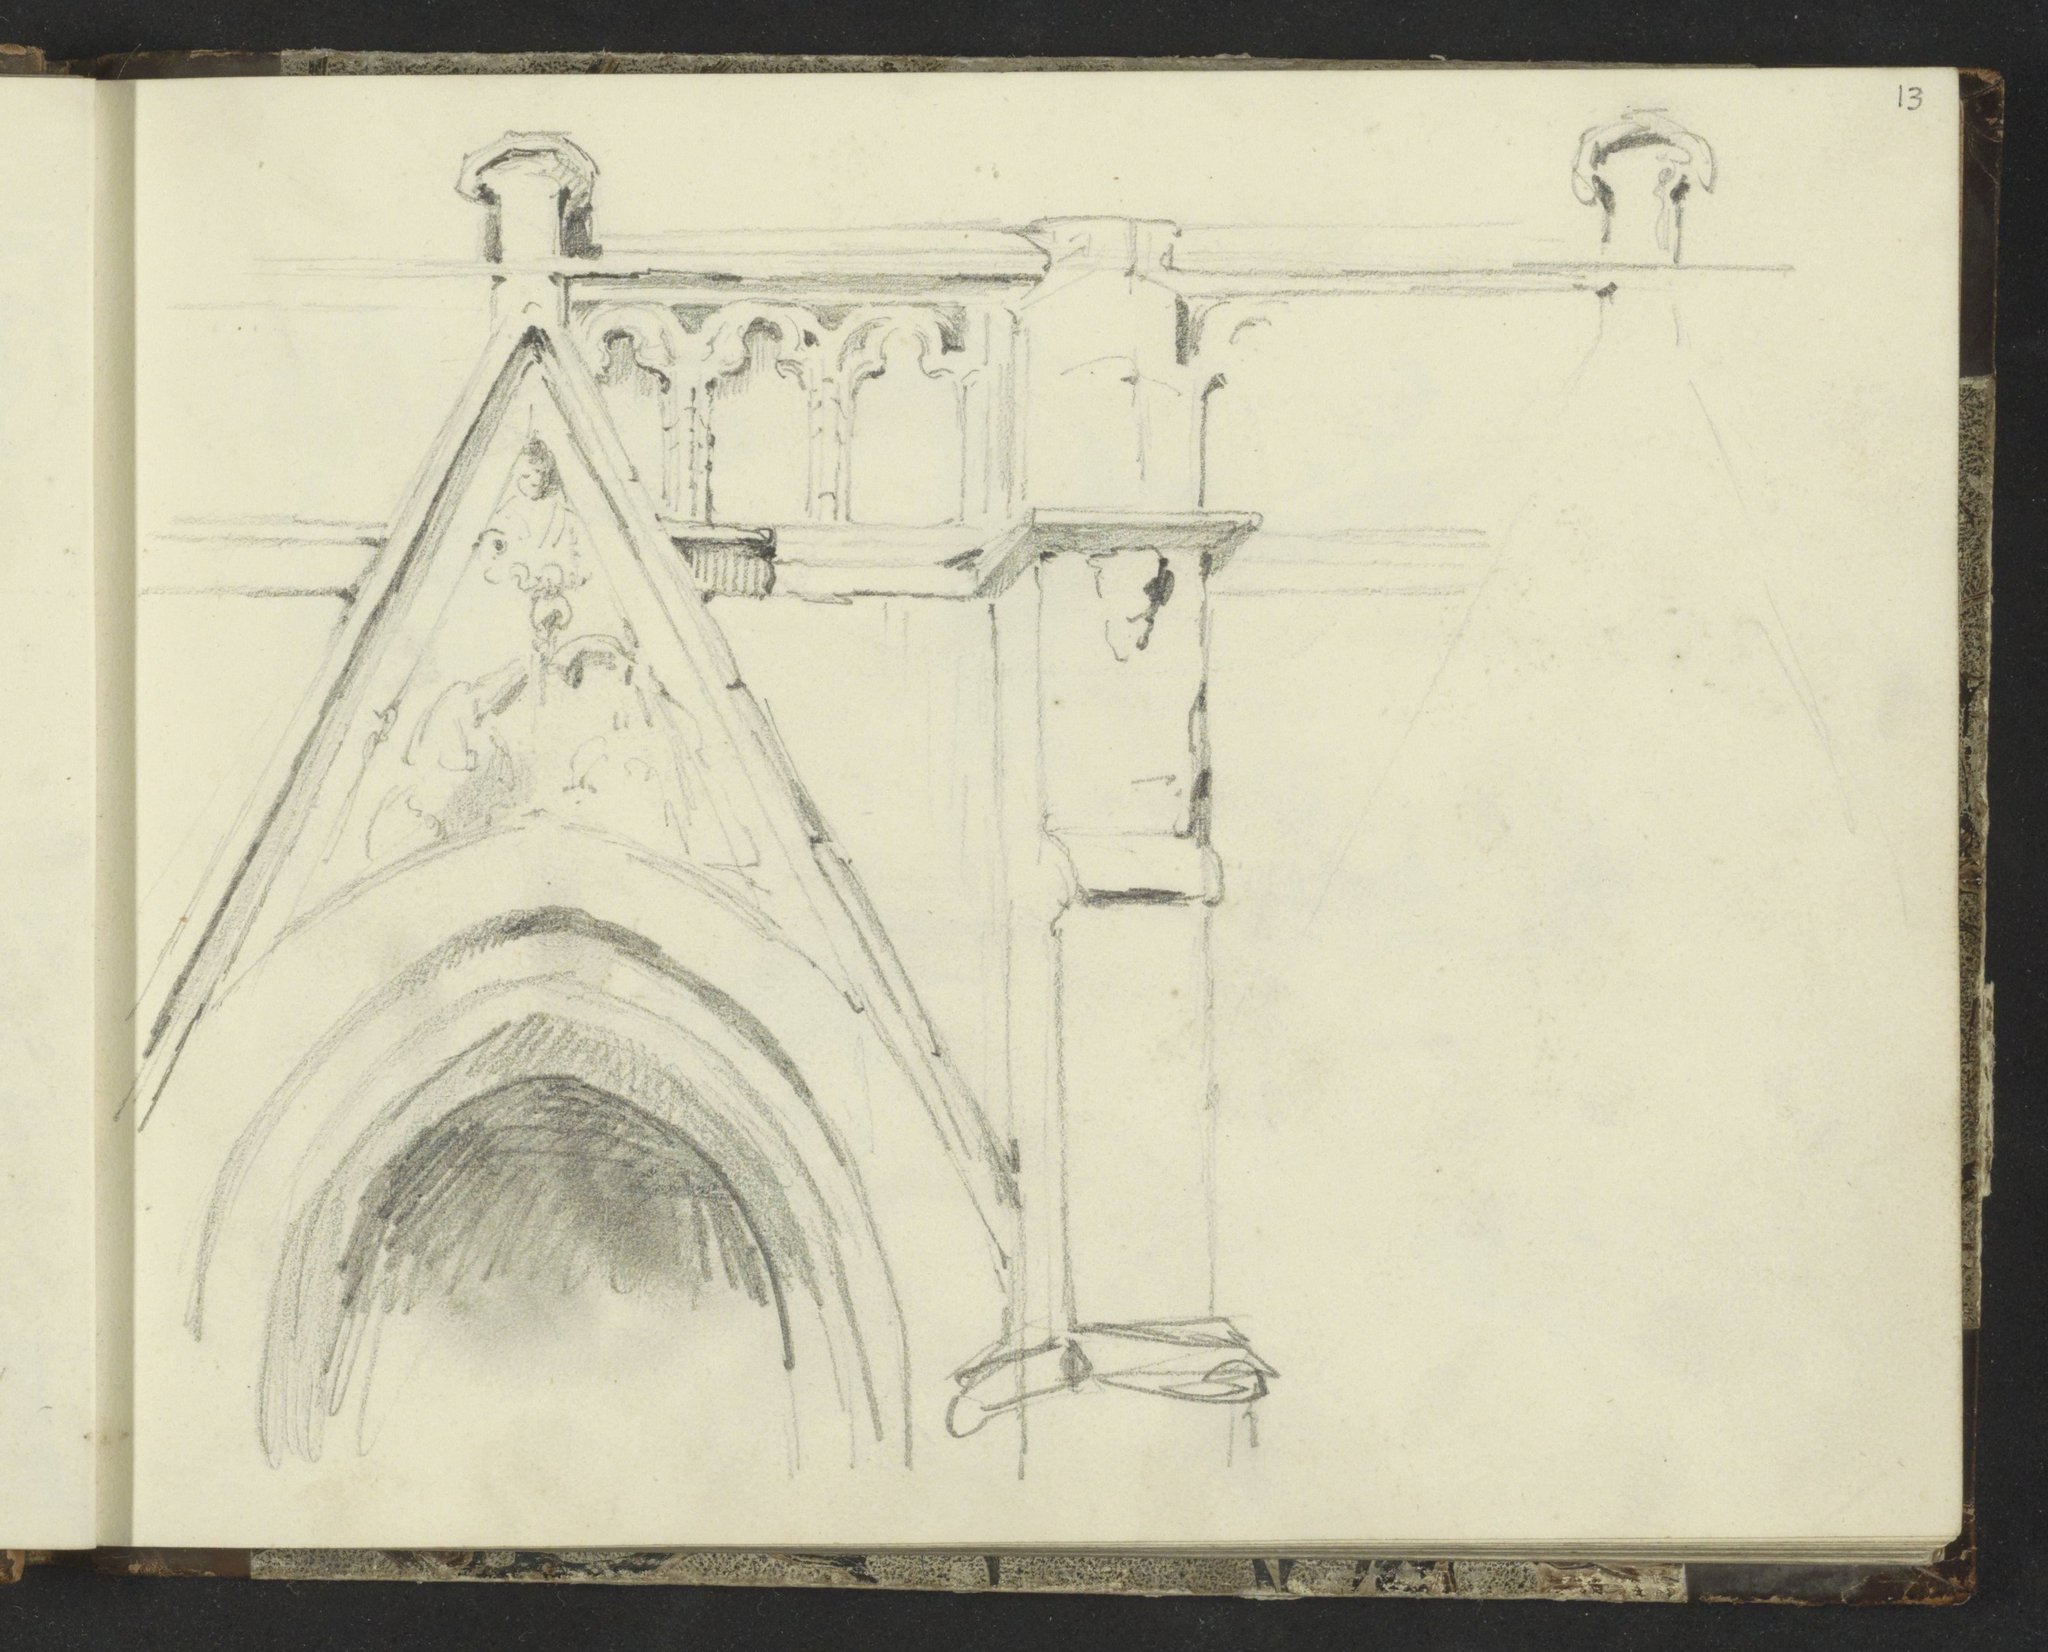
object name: sketchbook leaf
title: Gotisch frontaal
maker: willem hendrik schmidt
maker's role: draughtsman, painter, print maker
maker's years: 1809-1849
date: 1819-1849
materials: paper, pencil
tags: parts of church exterior and annexes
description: Blad 13 recto uit een schetsboek met 58 bladen.